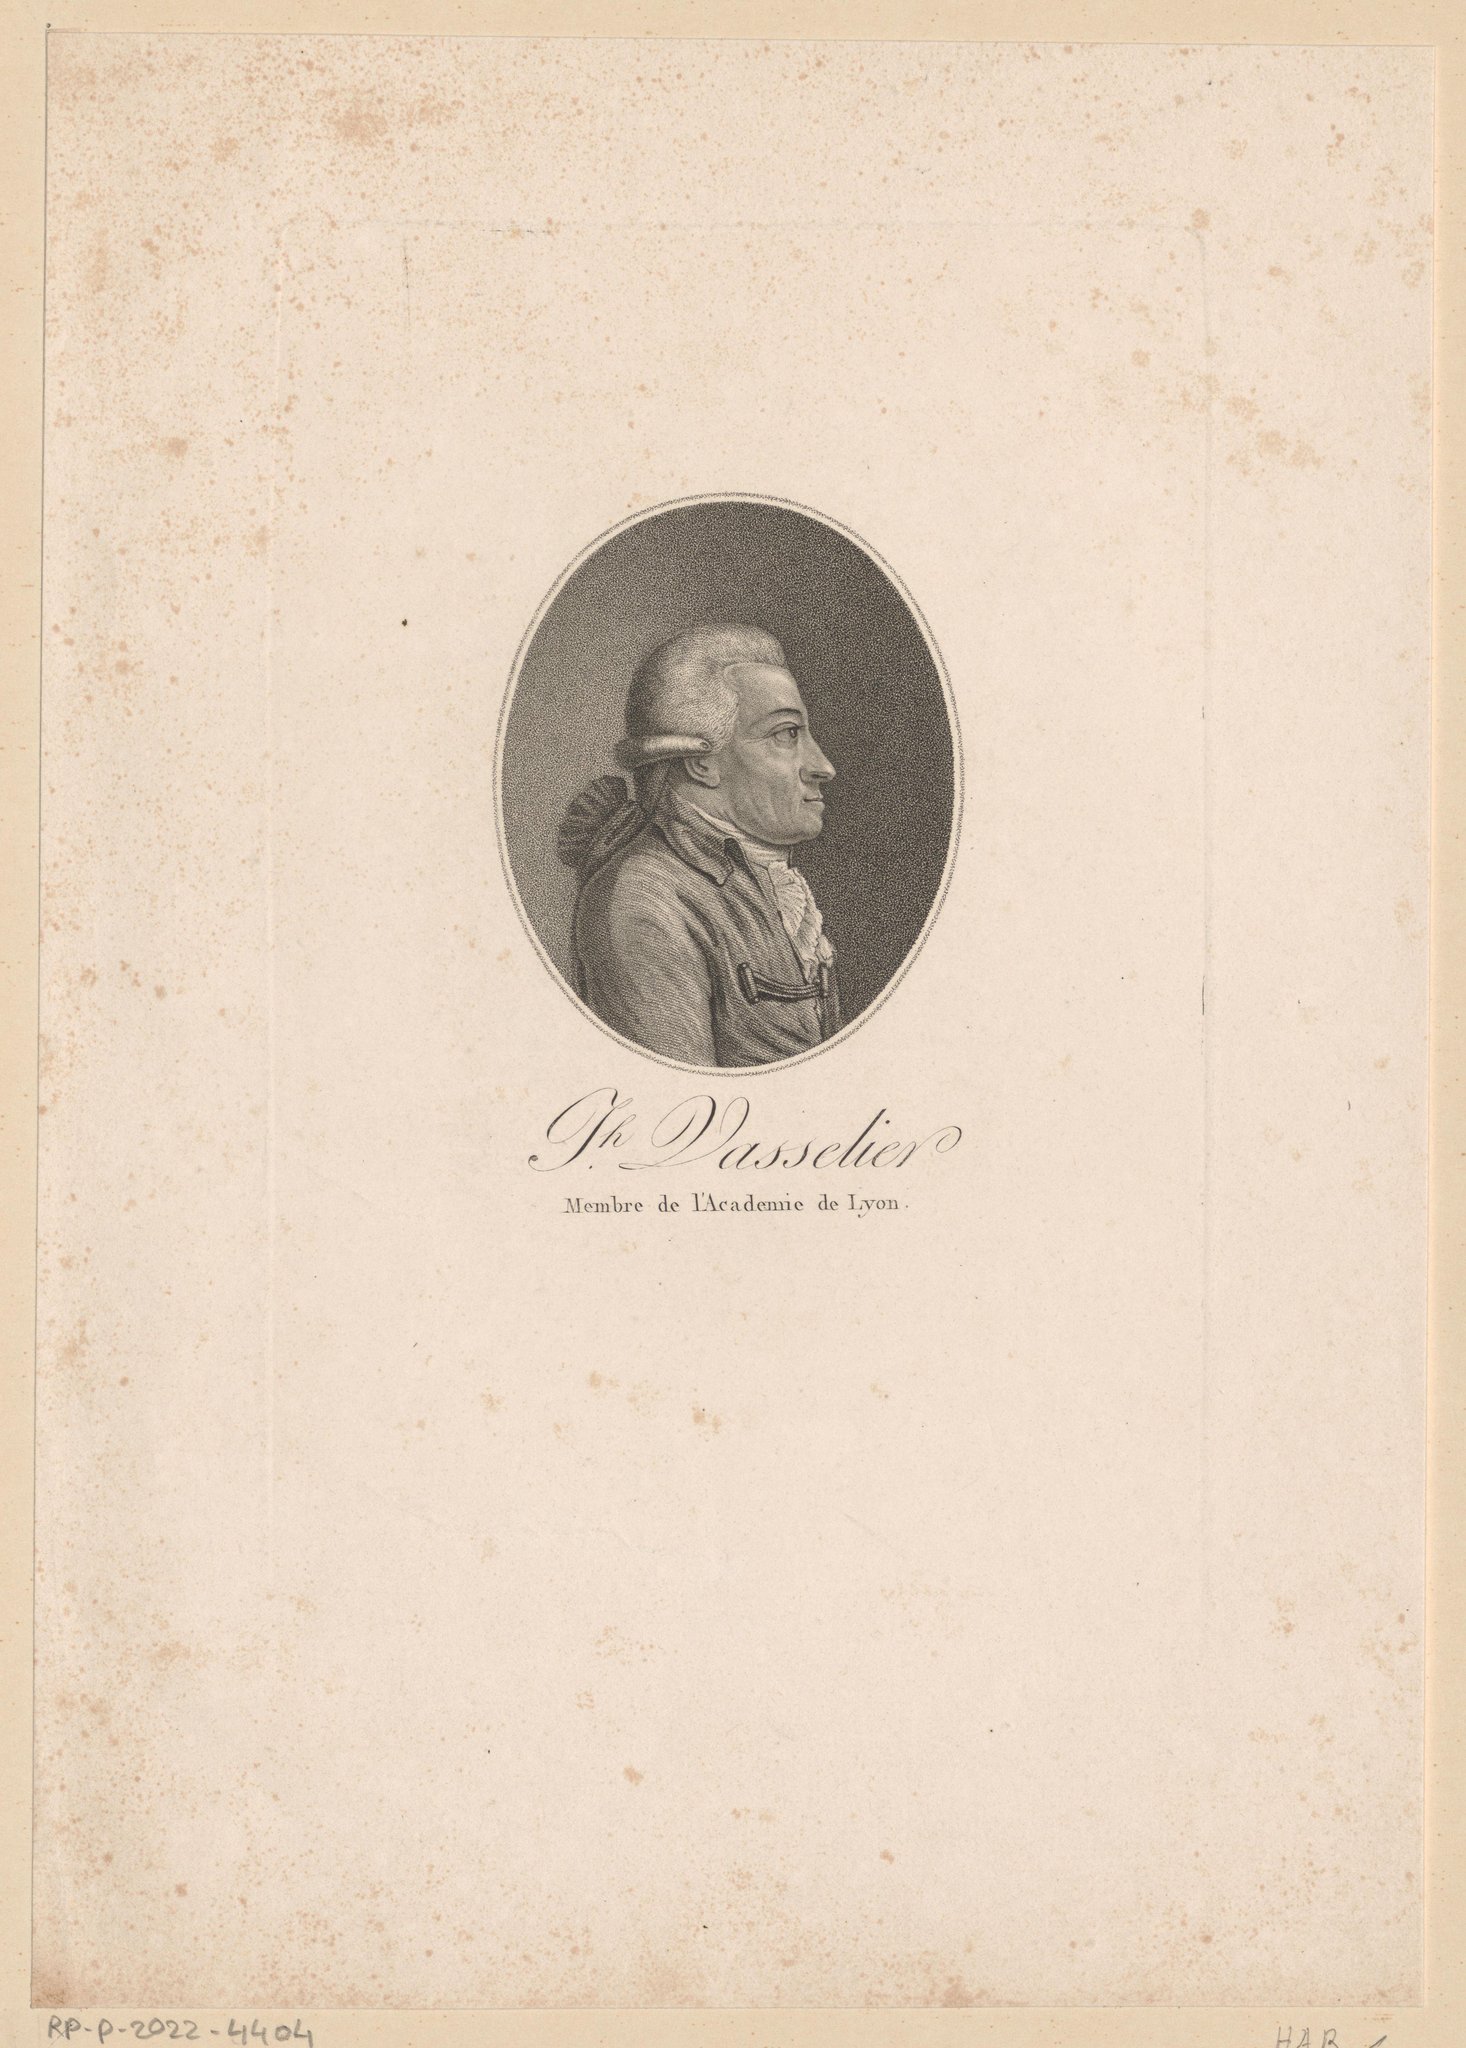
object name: print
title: Portret van Joseph Vasselier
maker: Anonymous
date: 1782-1830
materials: paper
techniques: etching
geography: france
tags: lyon, historical persons, portrait of a writer